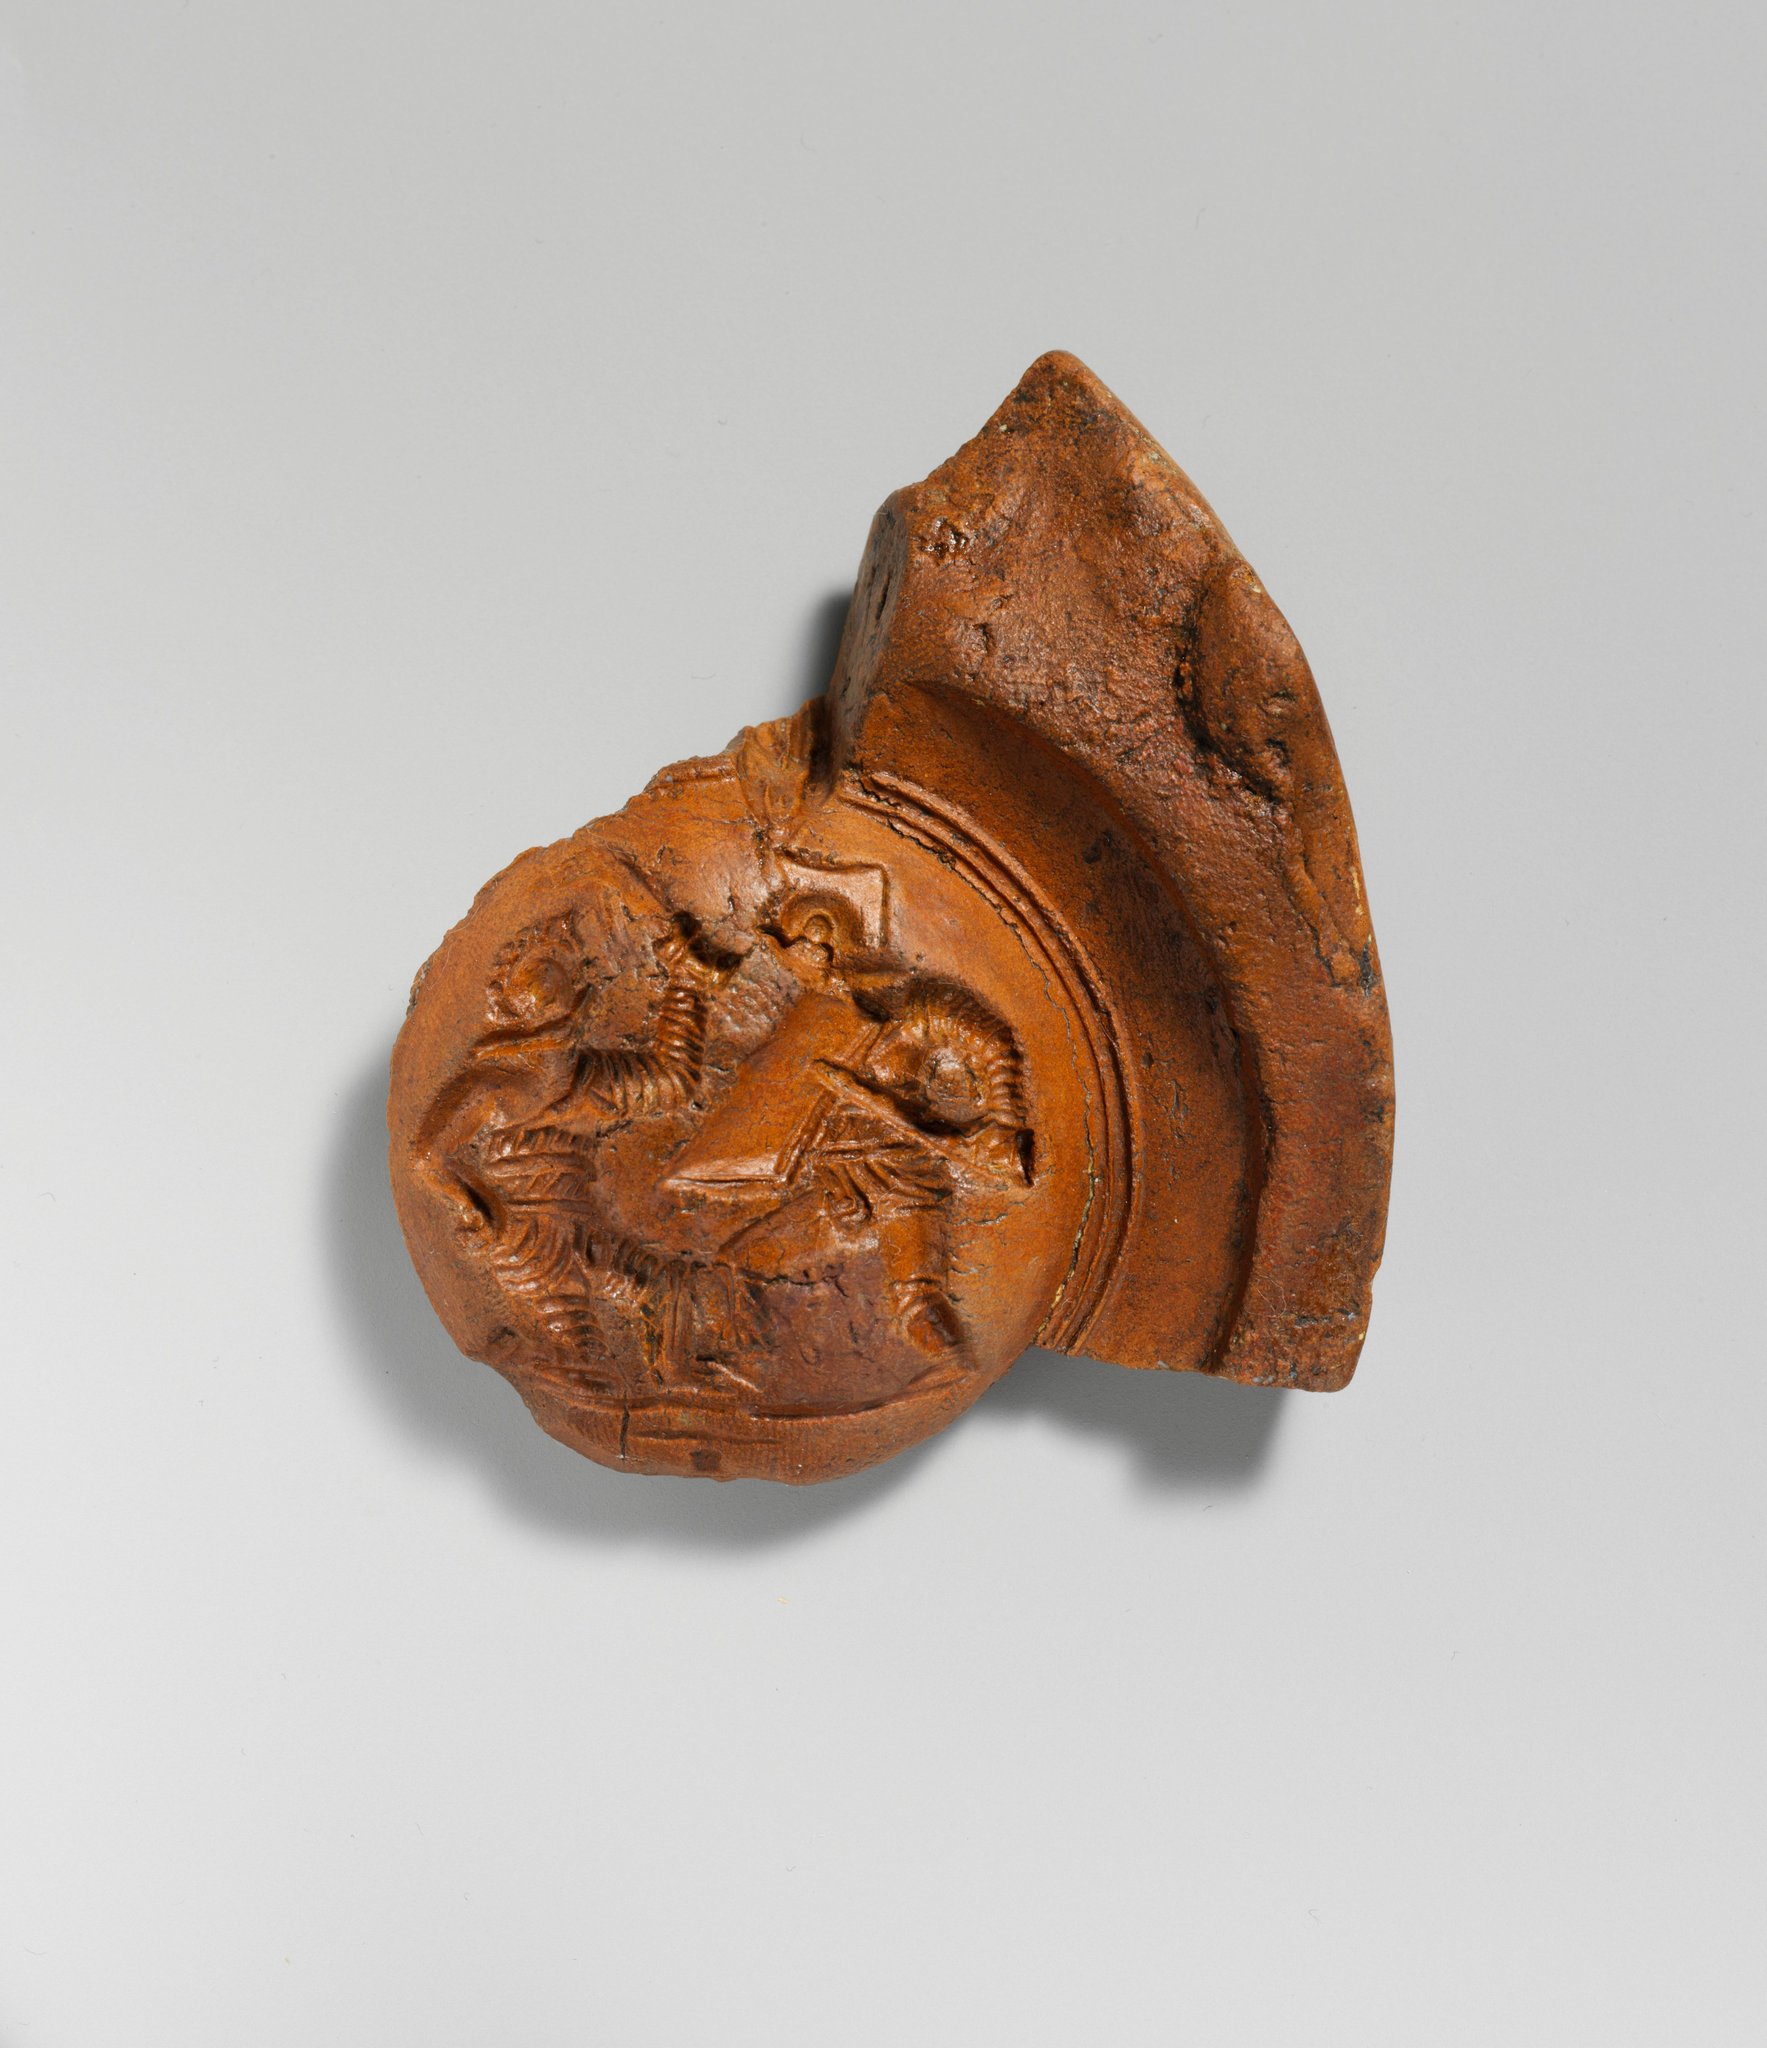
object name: lamp mold, top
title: Terracotta lamp mold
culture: roman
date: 1-200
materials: terracotta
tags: men,gladiators